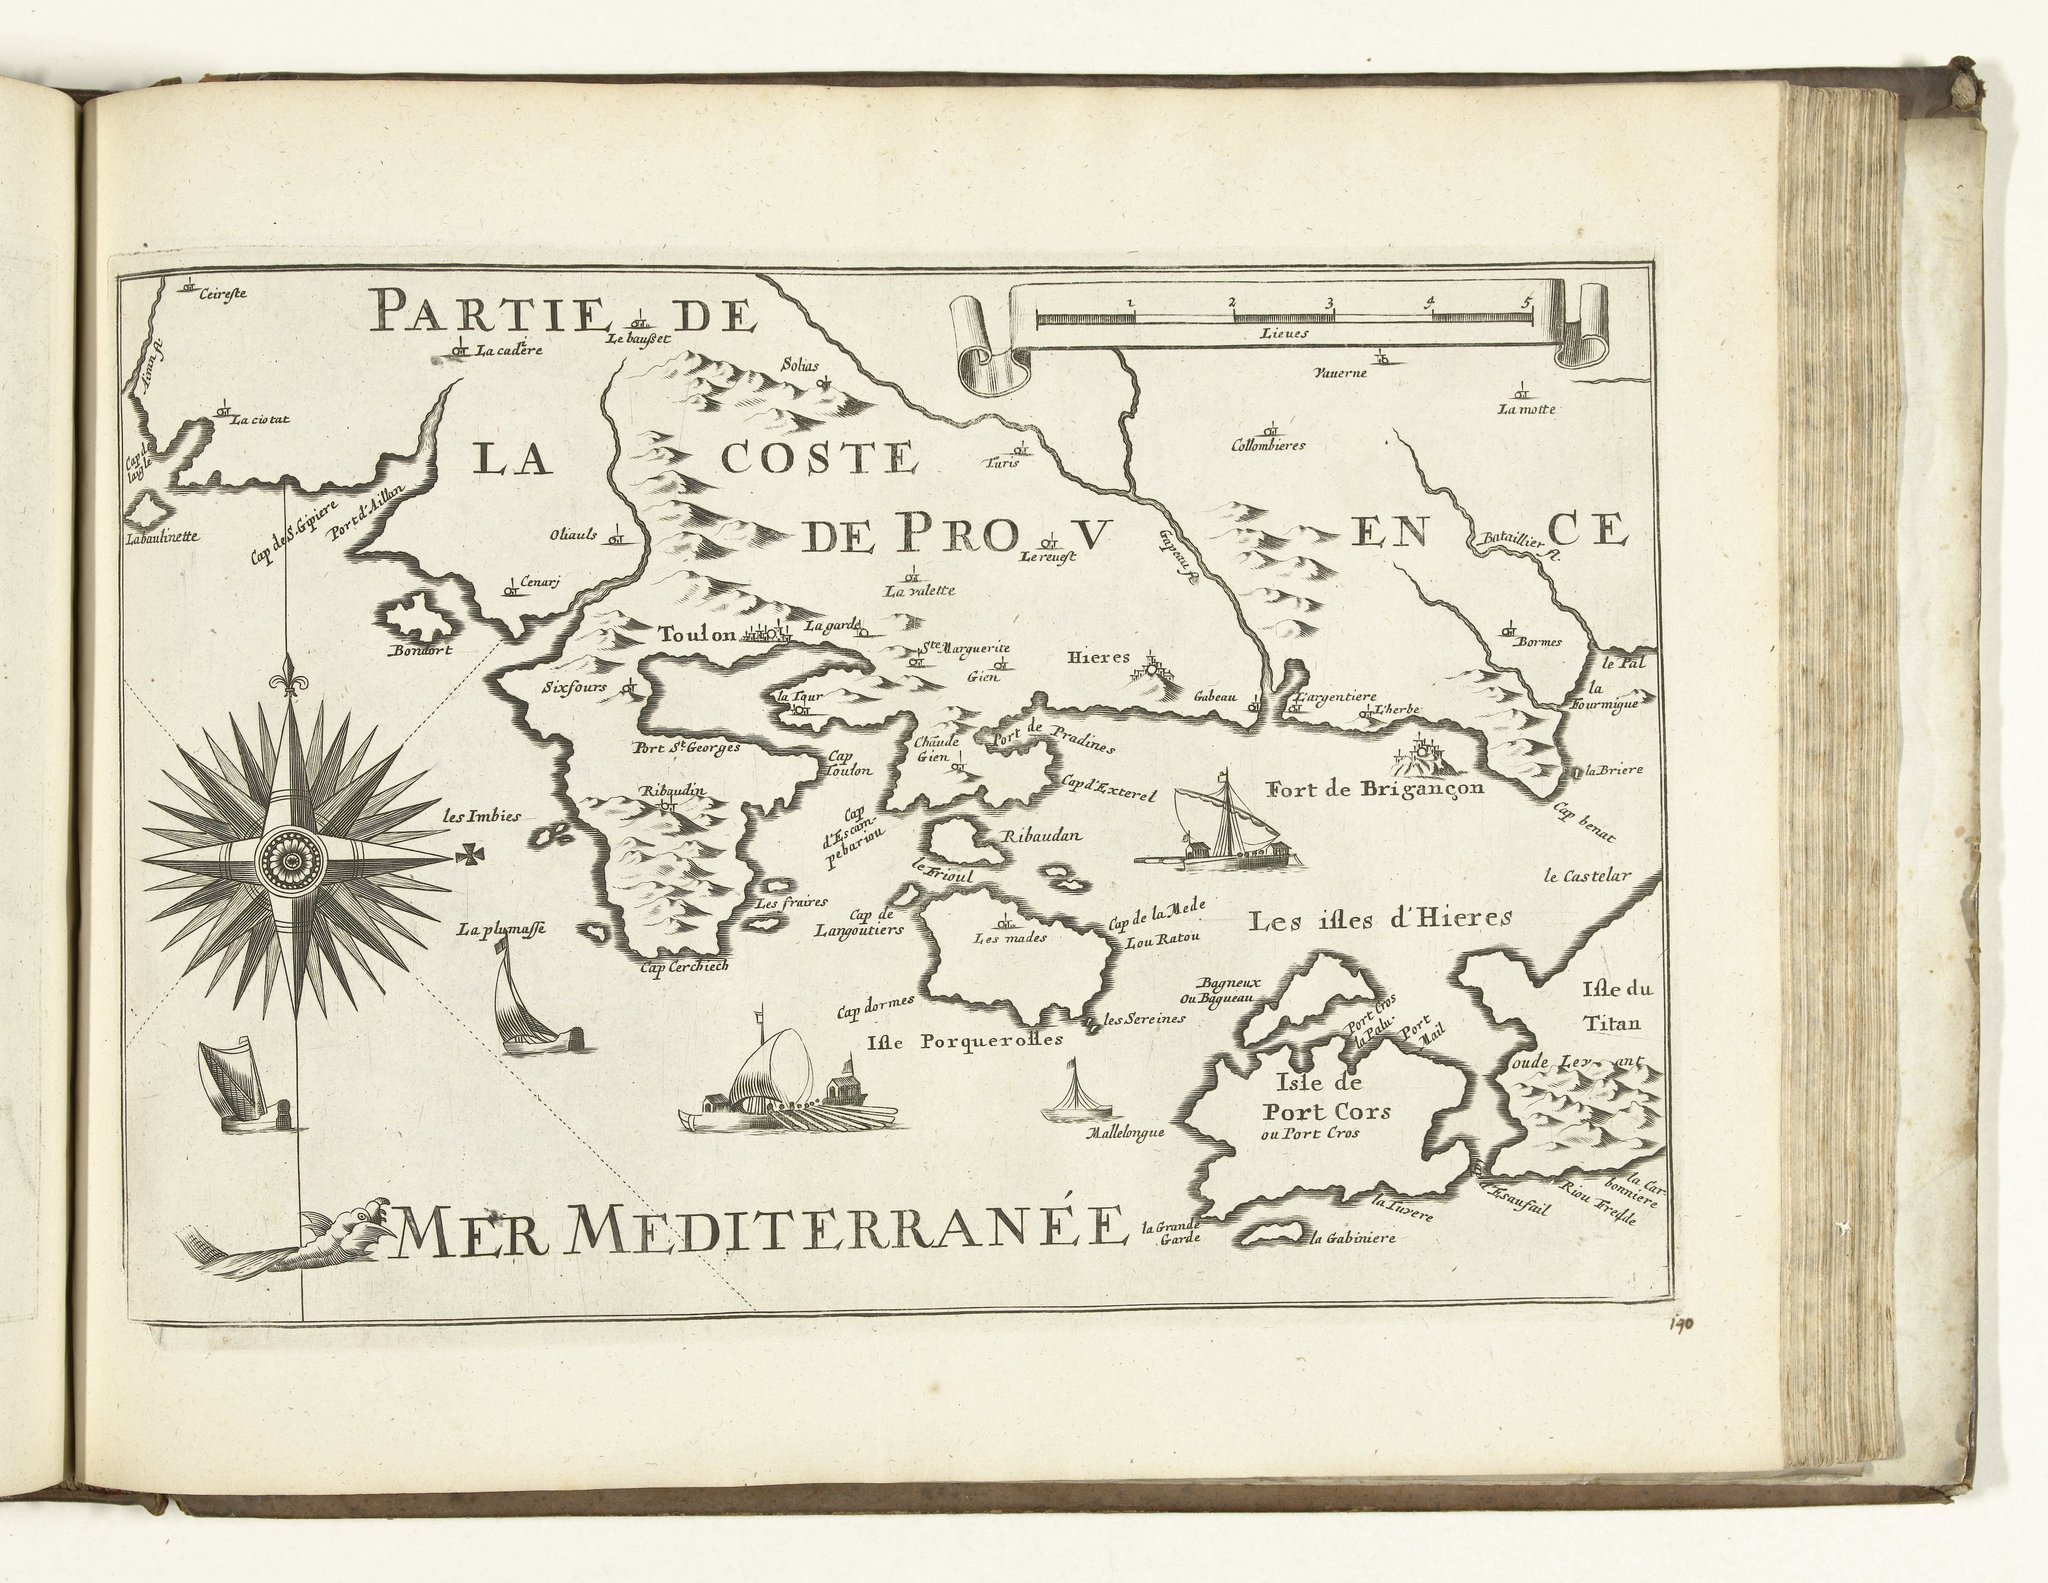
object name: print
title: Kaart van de Franse zuidkust bij Toulon, 1726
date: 1726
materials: paper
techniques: engraving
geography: northern netherlands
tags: maps of separate countries or regions, france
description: Kaart van de Franse zuidkust bij Toulon. Plaat nr. 140 in deel VI van het prentwerk: Les Forces de l'Europe, Asie, Afrique et Amerique ... Comme aussi les Cartes des Côtes de France et d'Espagne uit 1726, dit eerste deel met 238 met de hand genummerde platen van vermaarde sterke steden en vestingen in het kader van de Spaanse Successieoorlog 1701-1713. Voor het merendeel zijn deze platen gekopieerd naar de anonieme Franse platen van vermaarde sterke steden en vestingen: in Les forces de l'Europe en in: Le theatre de la guerre, dans les Pays-Bas, beide oorspronkelijk uitgegeven door Nicolas de Fer te Parijs (1693-1697) in het kader van de Negenjarige Oorlog. Opschriften in het Frans.